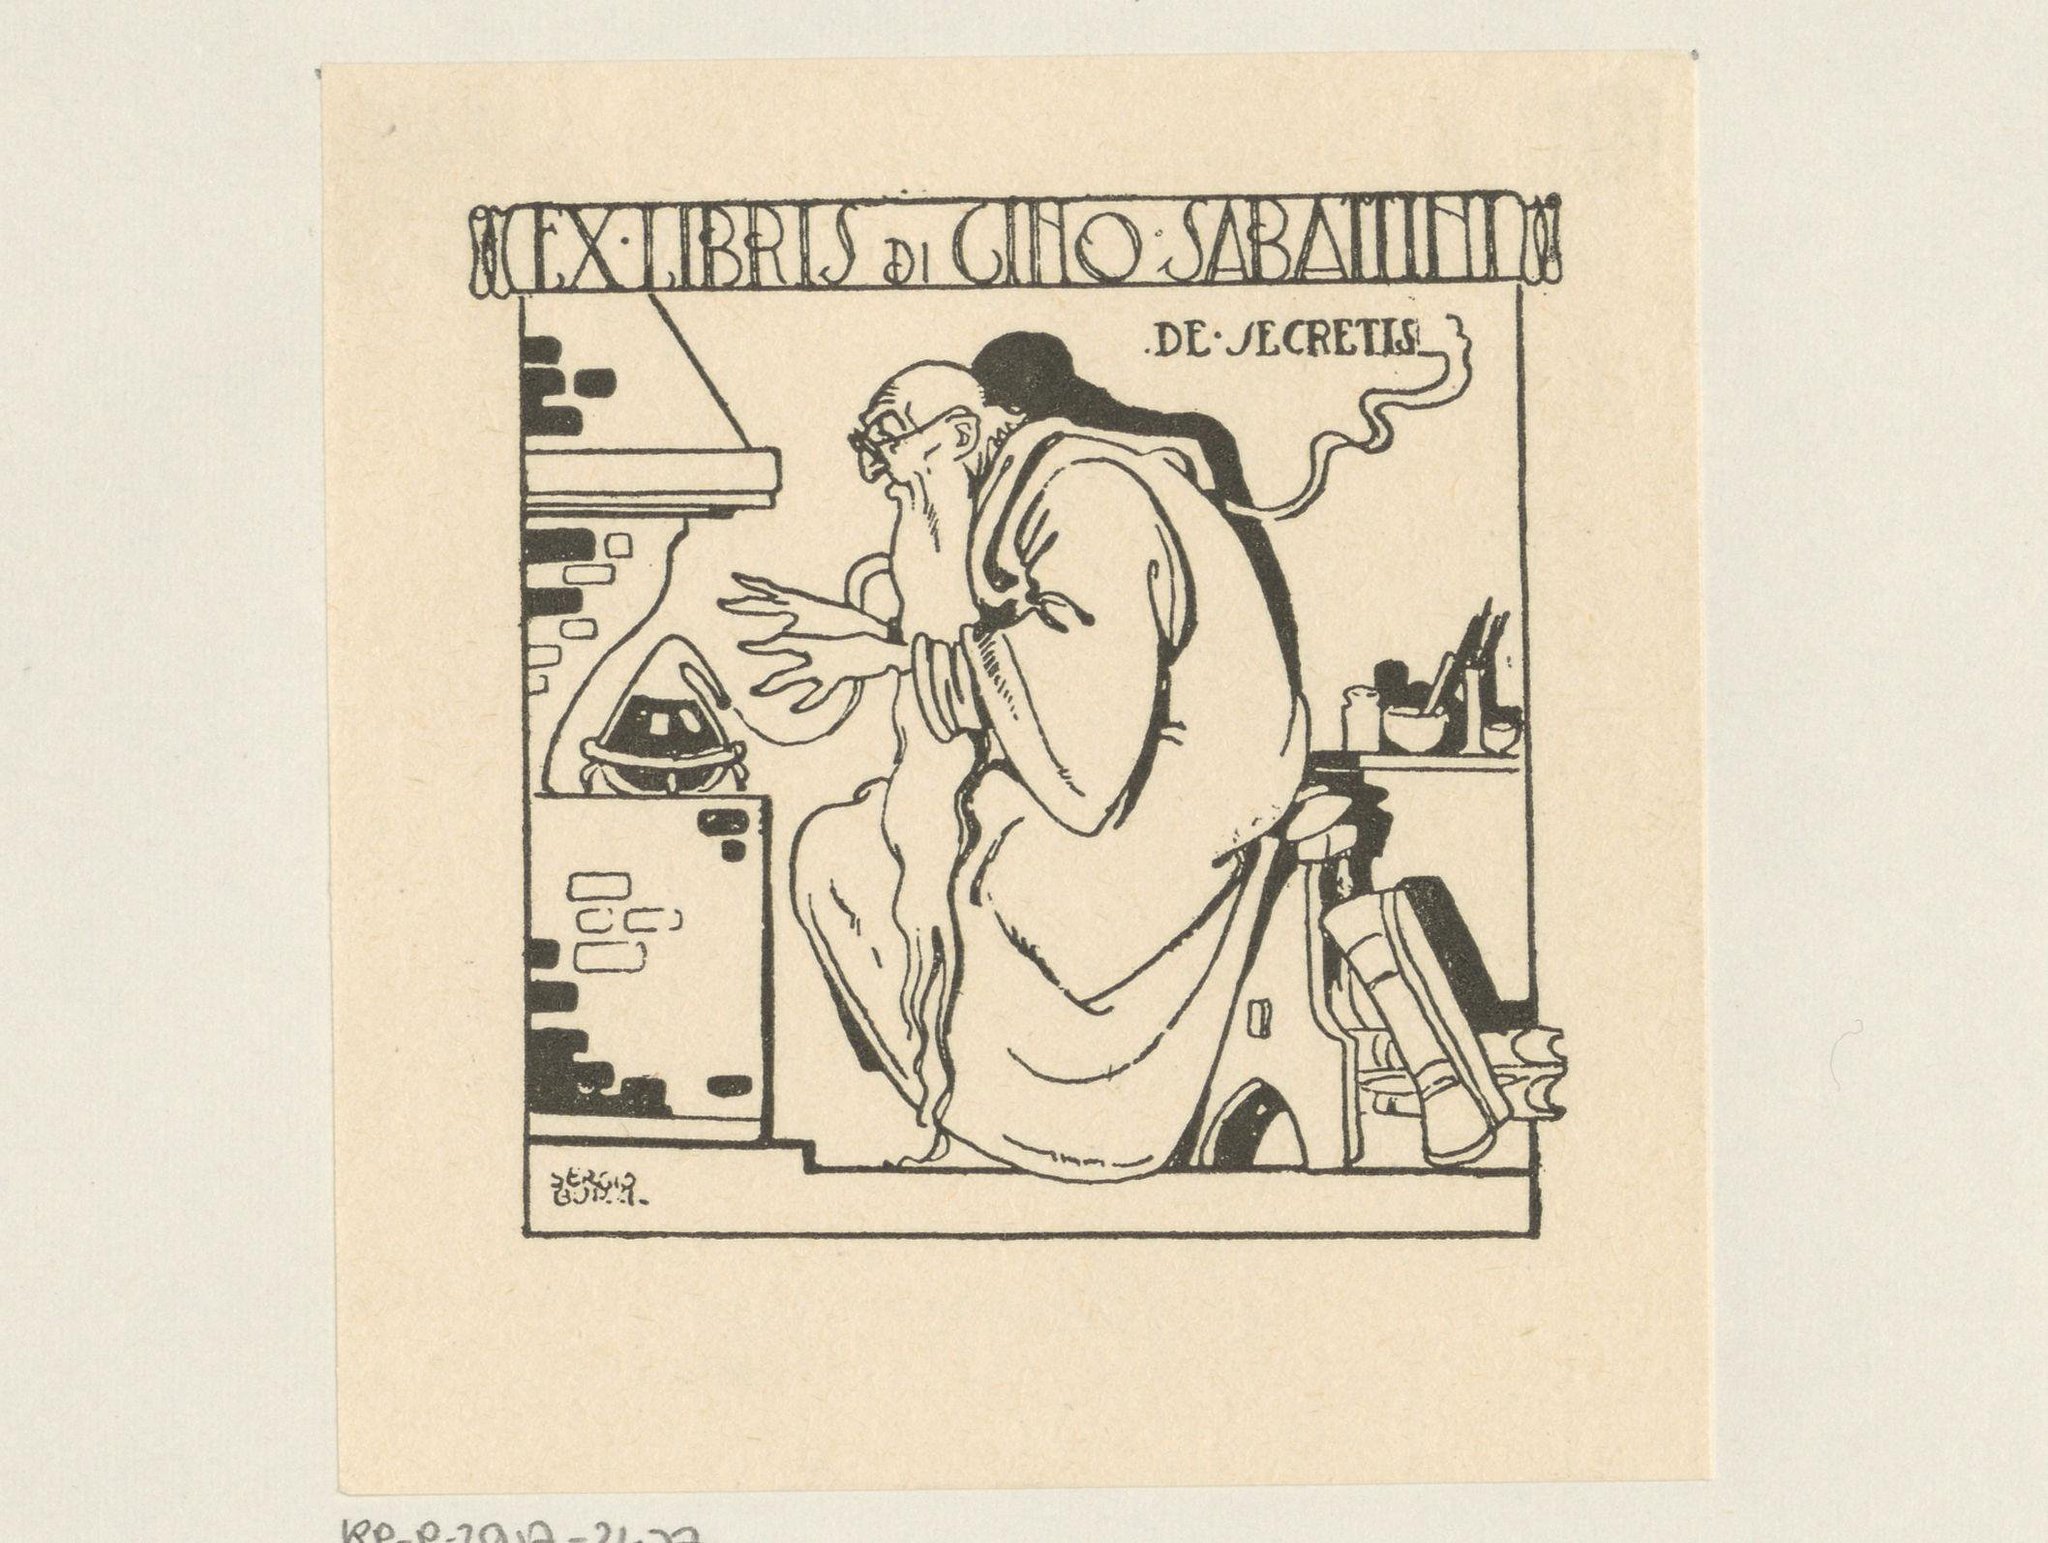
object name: bookplate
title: Ex libris van Gino Sabattini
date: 1949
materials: paper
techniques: printing block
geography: italy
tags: gino sabattini, sitting figure, old man, alchemist at work, hearth and stove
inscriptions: inscription: ‘S. Burzi 1949’